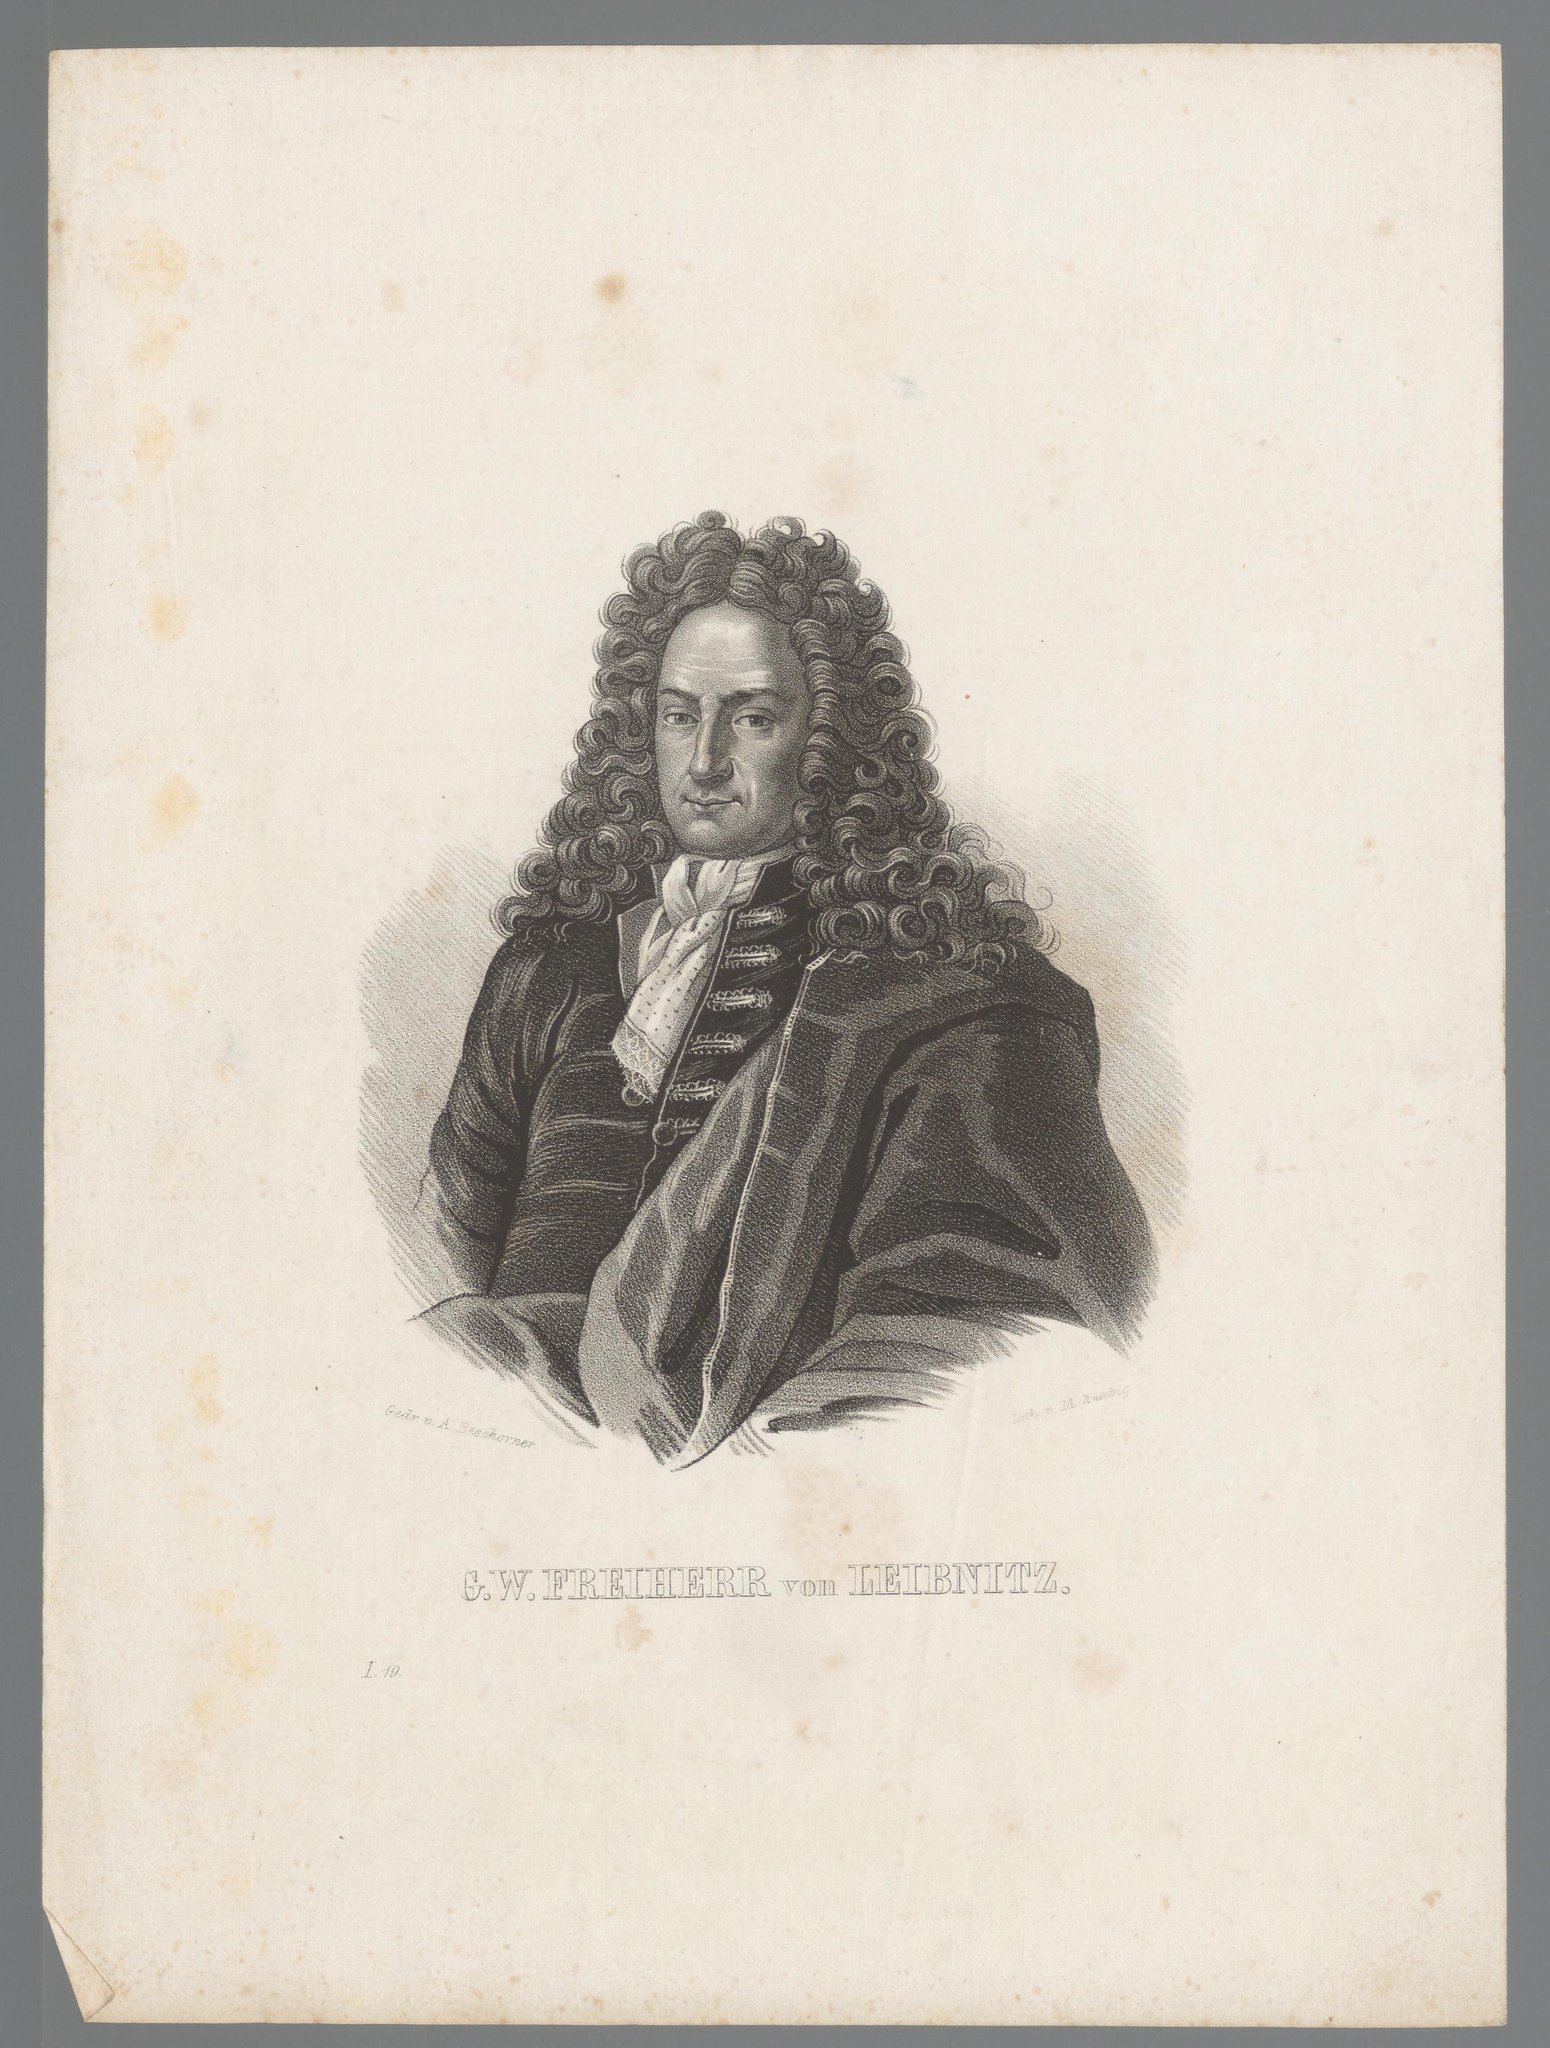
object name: print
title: G.W. Freiherr von Leibnitz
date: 1814-1876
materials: paper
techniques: lithograph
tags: adult man, historical persons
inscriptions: collector's mark: Lugt 2228